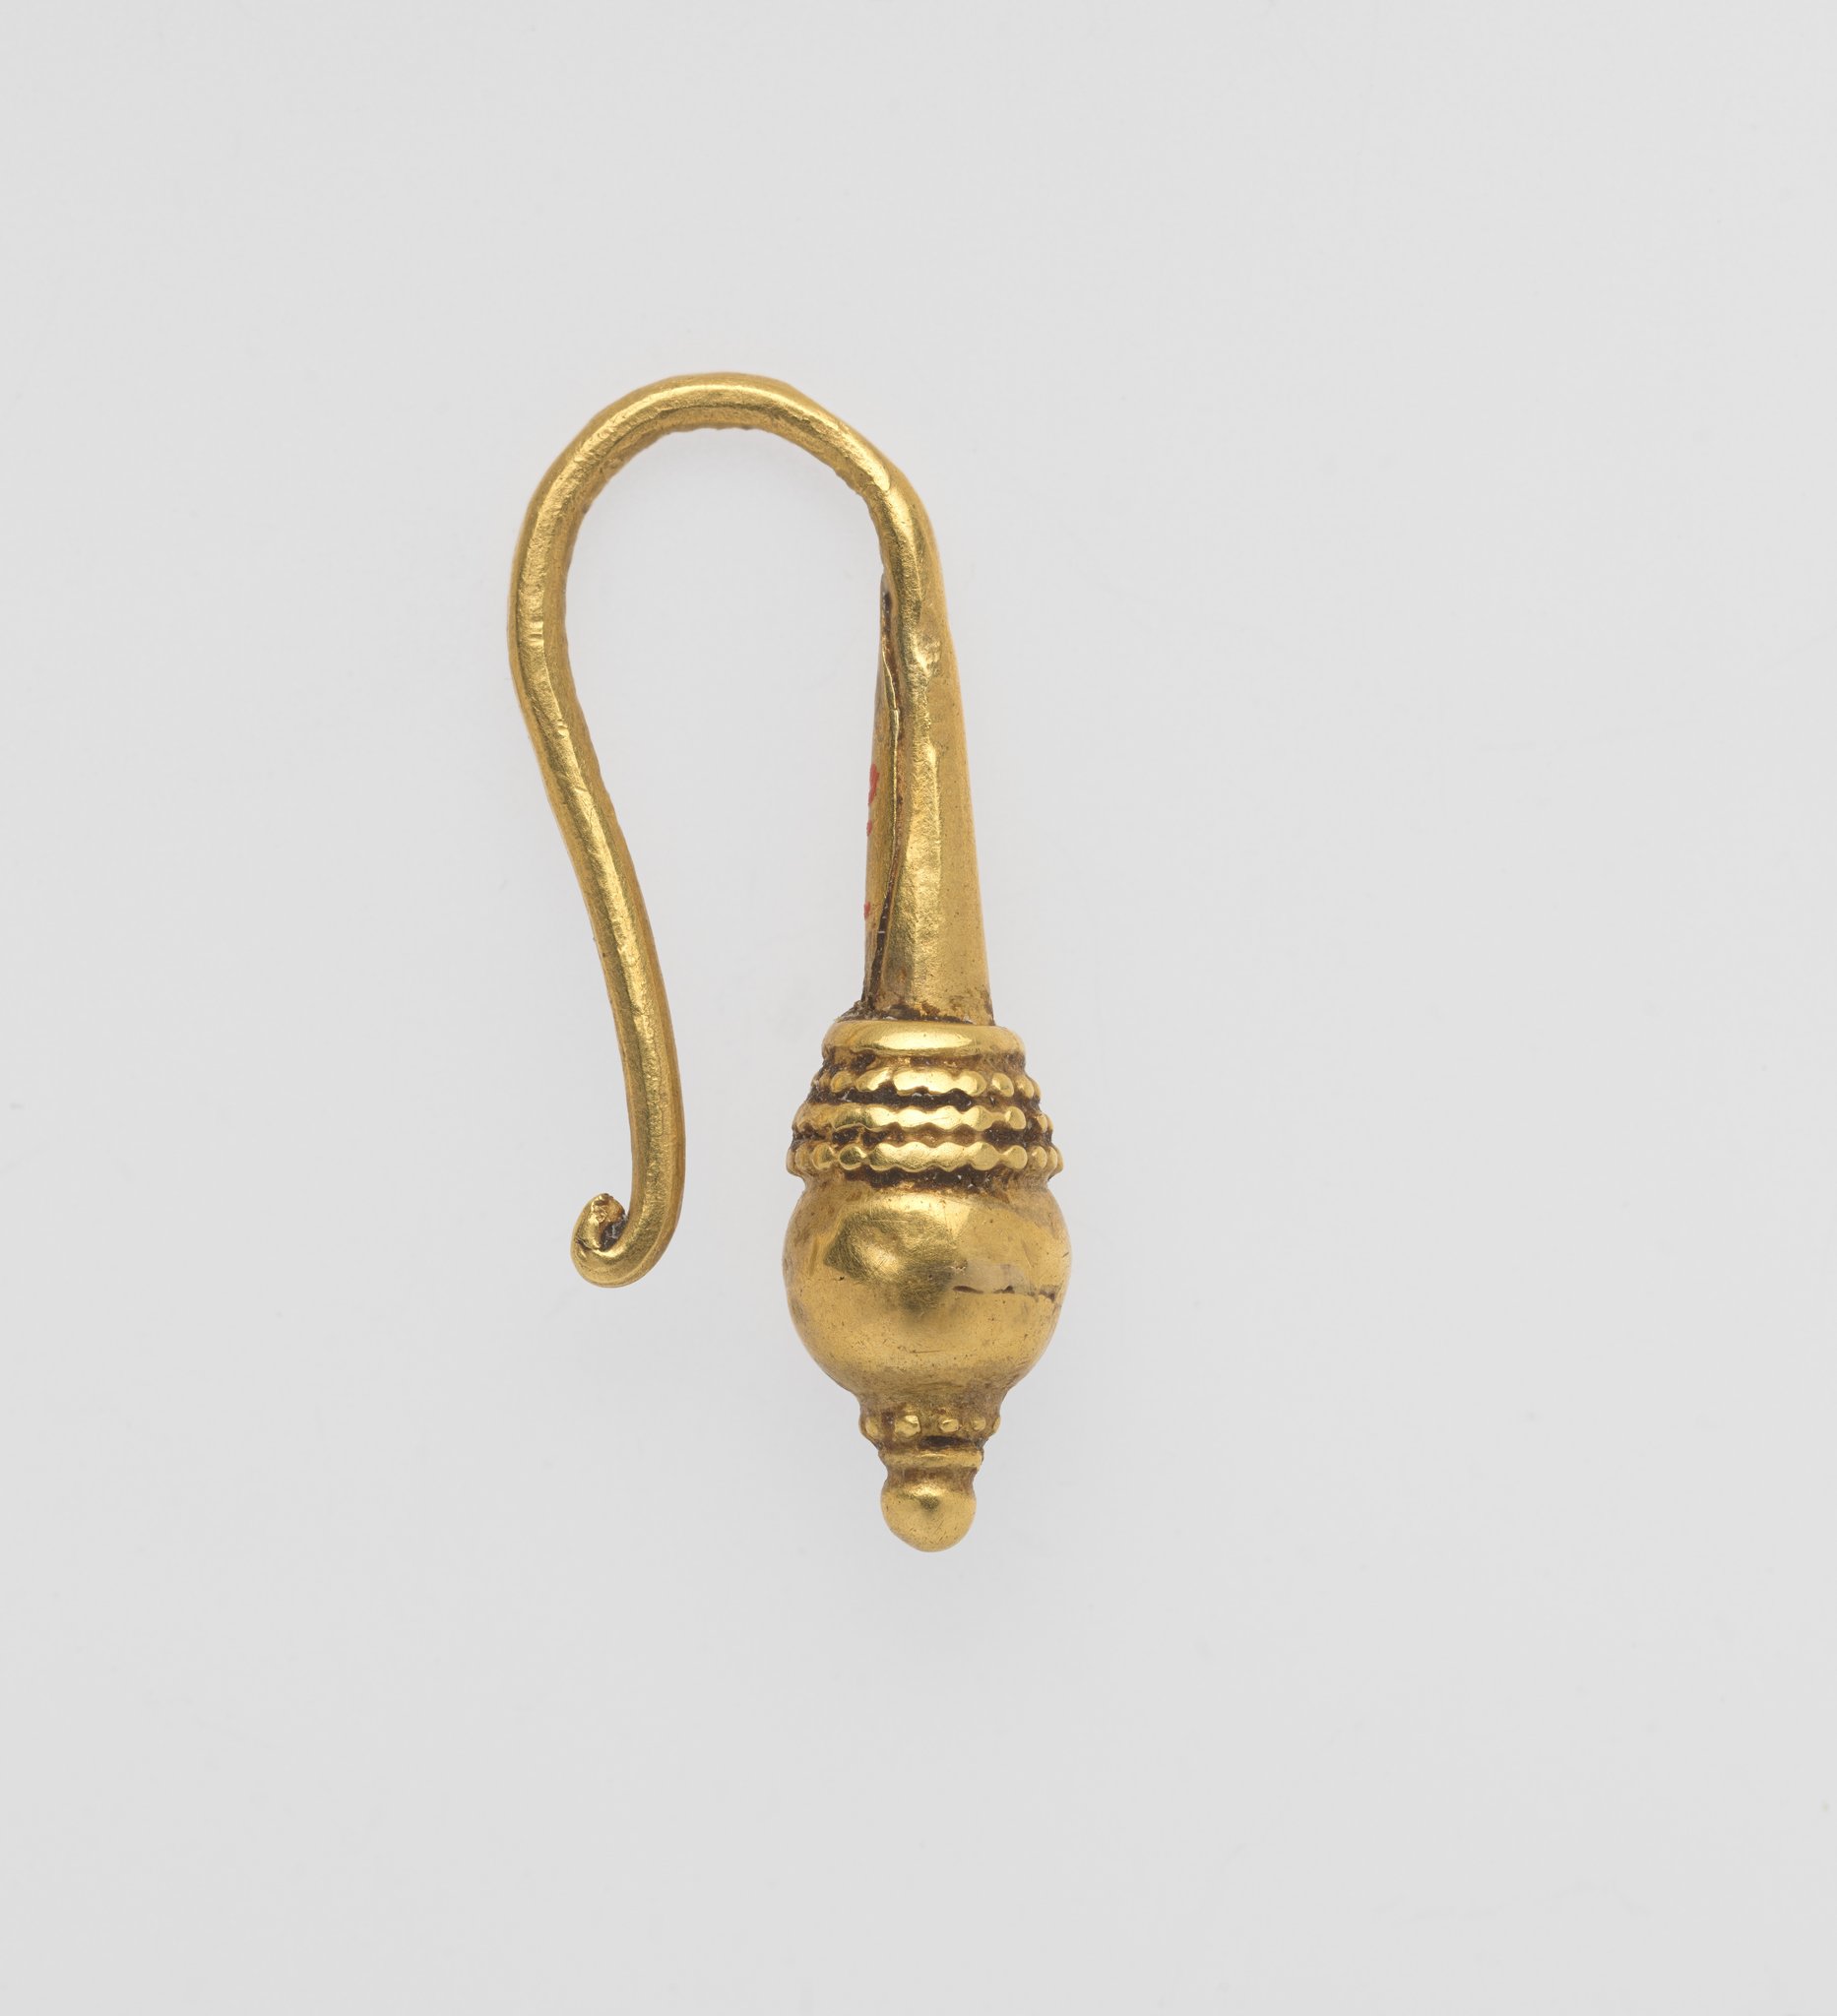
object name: earring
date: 1701-1900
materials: gold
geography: india